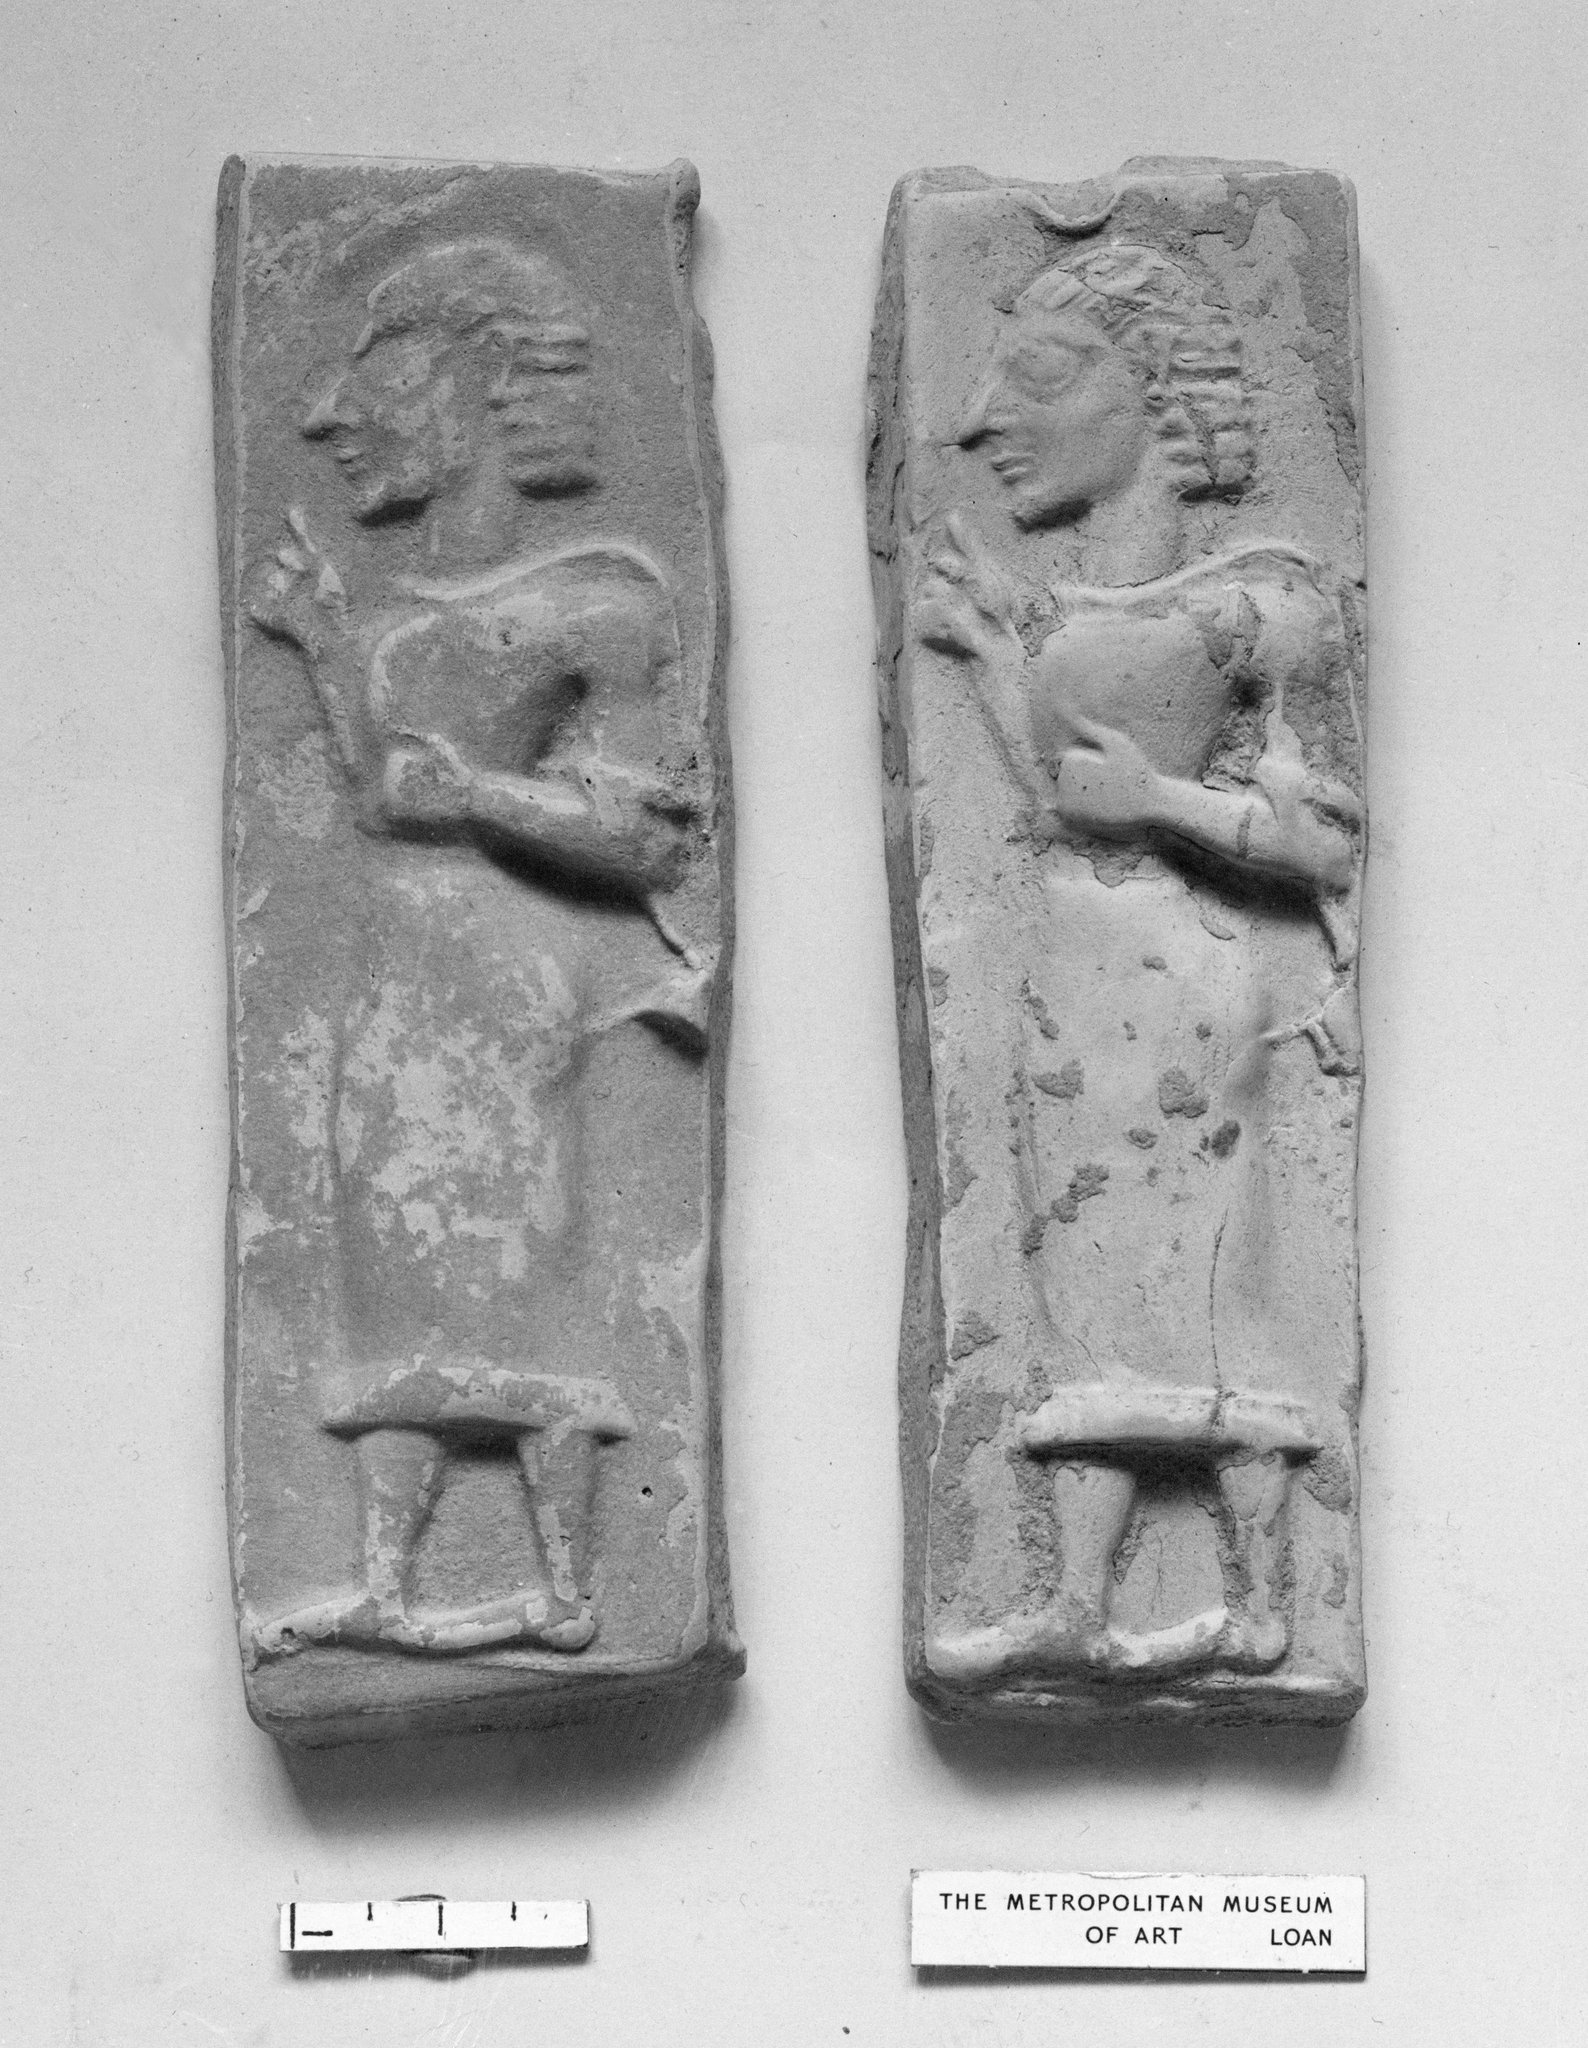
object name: pinax, figure in tunic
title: Terracotta plaque with a striding male figure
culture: greek, cretan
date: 700-601 BCE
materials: terracotta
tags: men